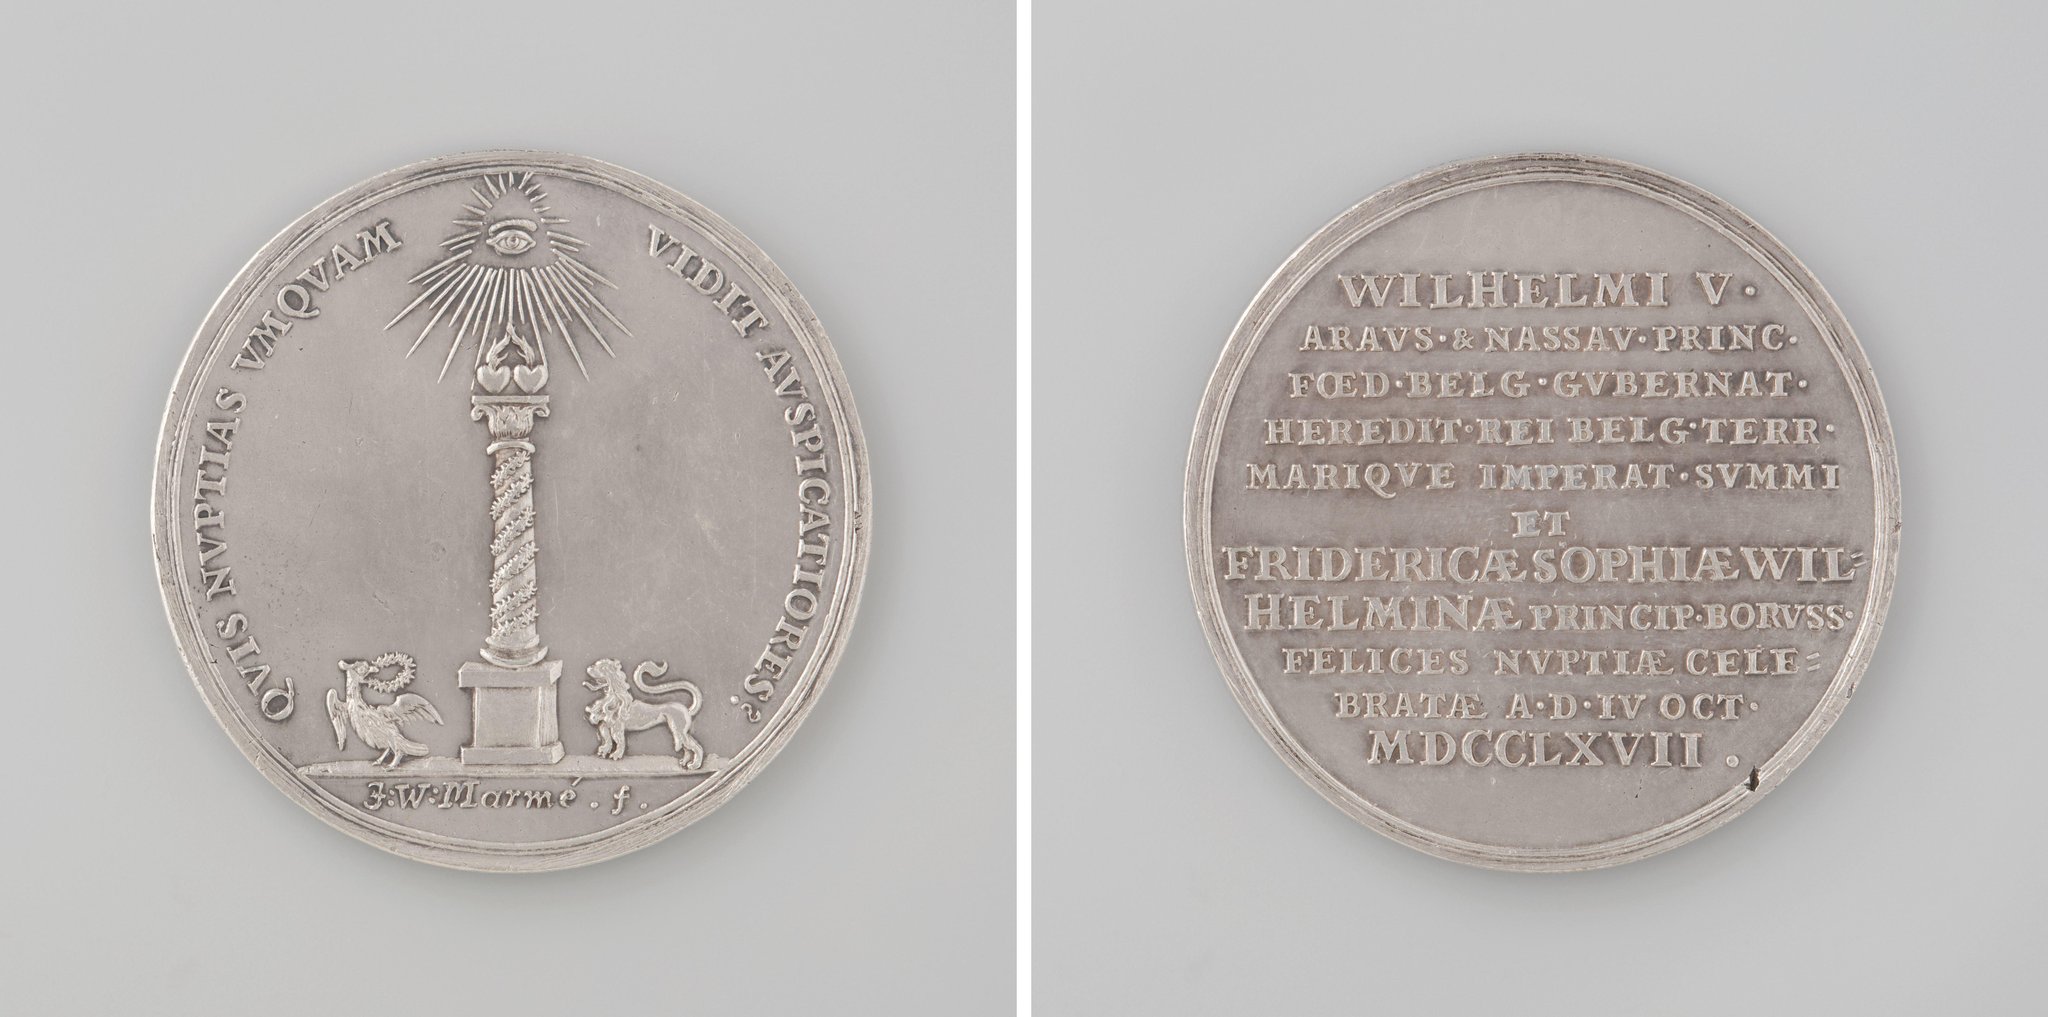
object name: history medal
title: Huwelijk van Willem V met Wilhelmina Frederica Sophia van Pruisen te Berlijn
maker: jan willem marme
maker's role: medailleur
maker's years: -1826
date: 1767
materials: silver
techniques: striking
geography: utrecht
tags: the hague, william v (prince of orange), berlin, painter, draughtsman, wilhelmina of prussia (princess of orange)